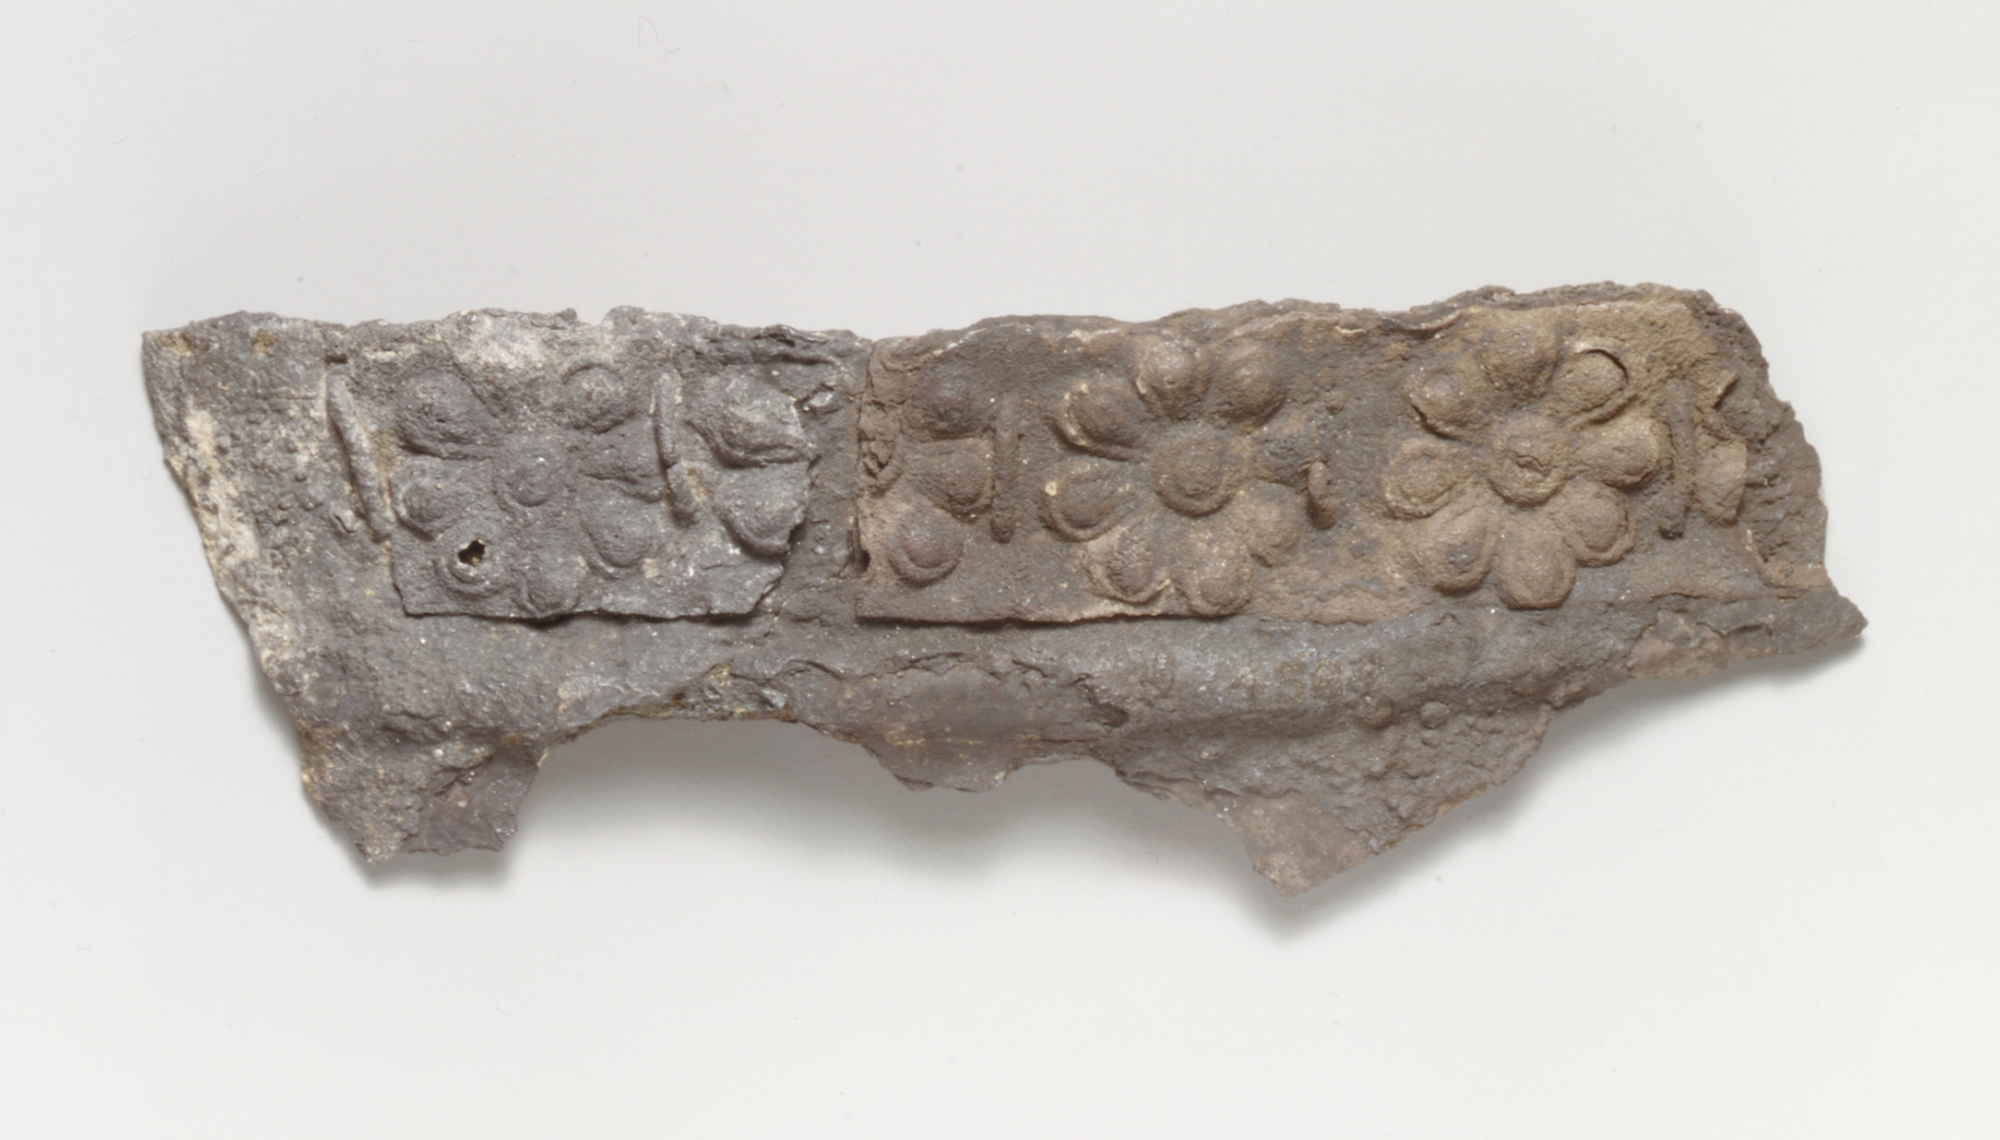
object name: bowl rim with rosette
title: Bowl rim with rosettes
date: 600-401 BCE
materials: silver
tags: flowers